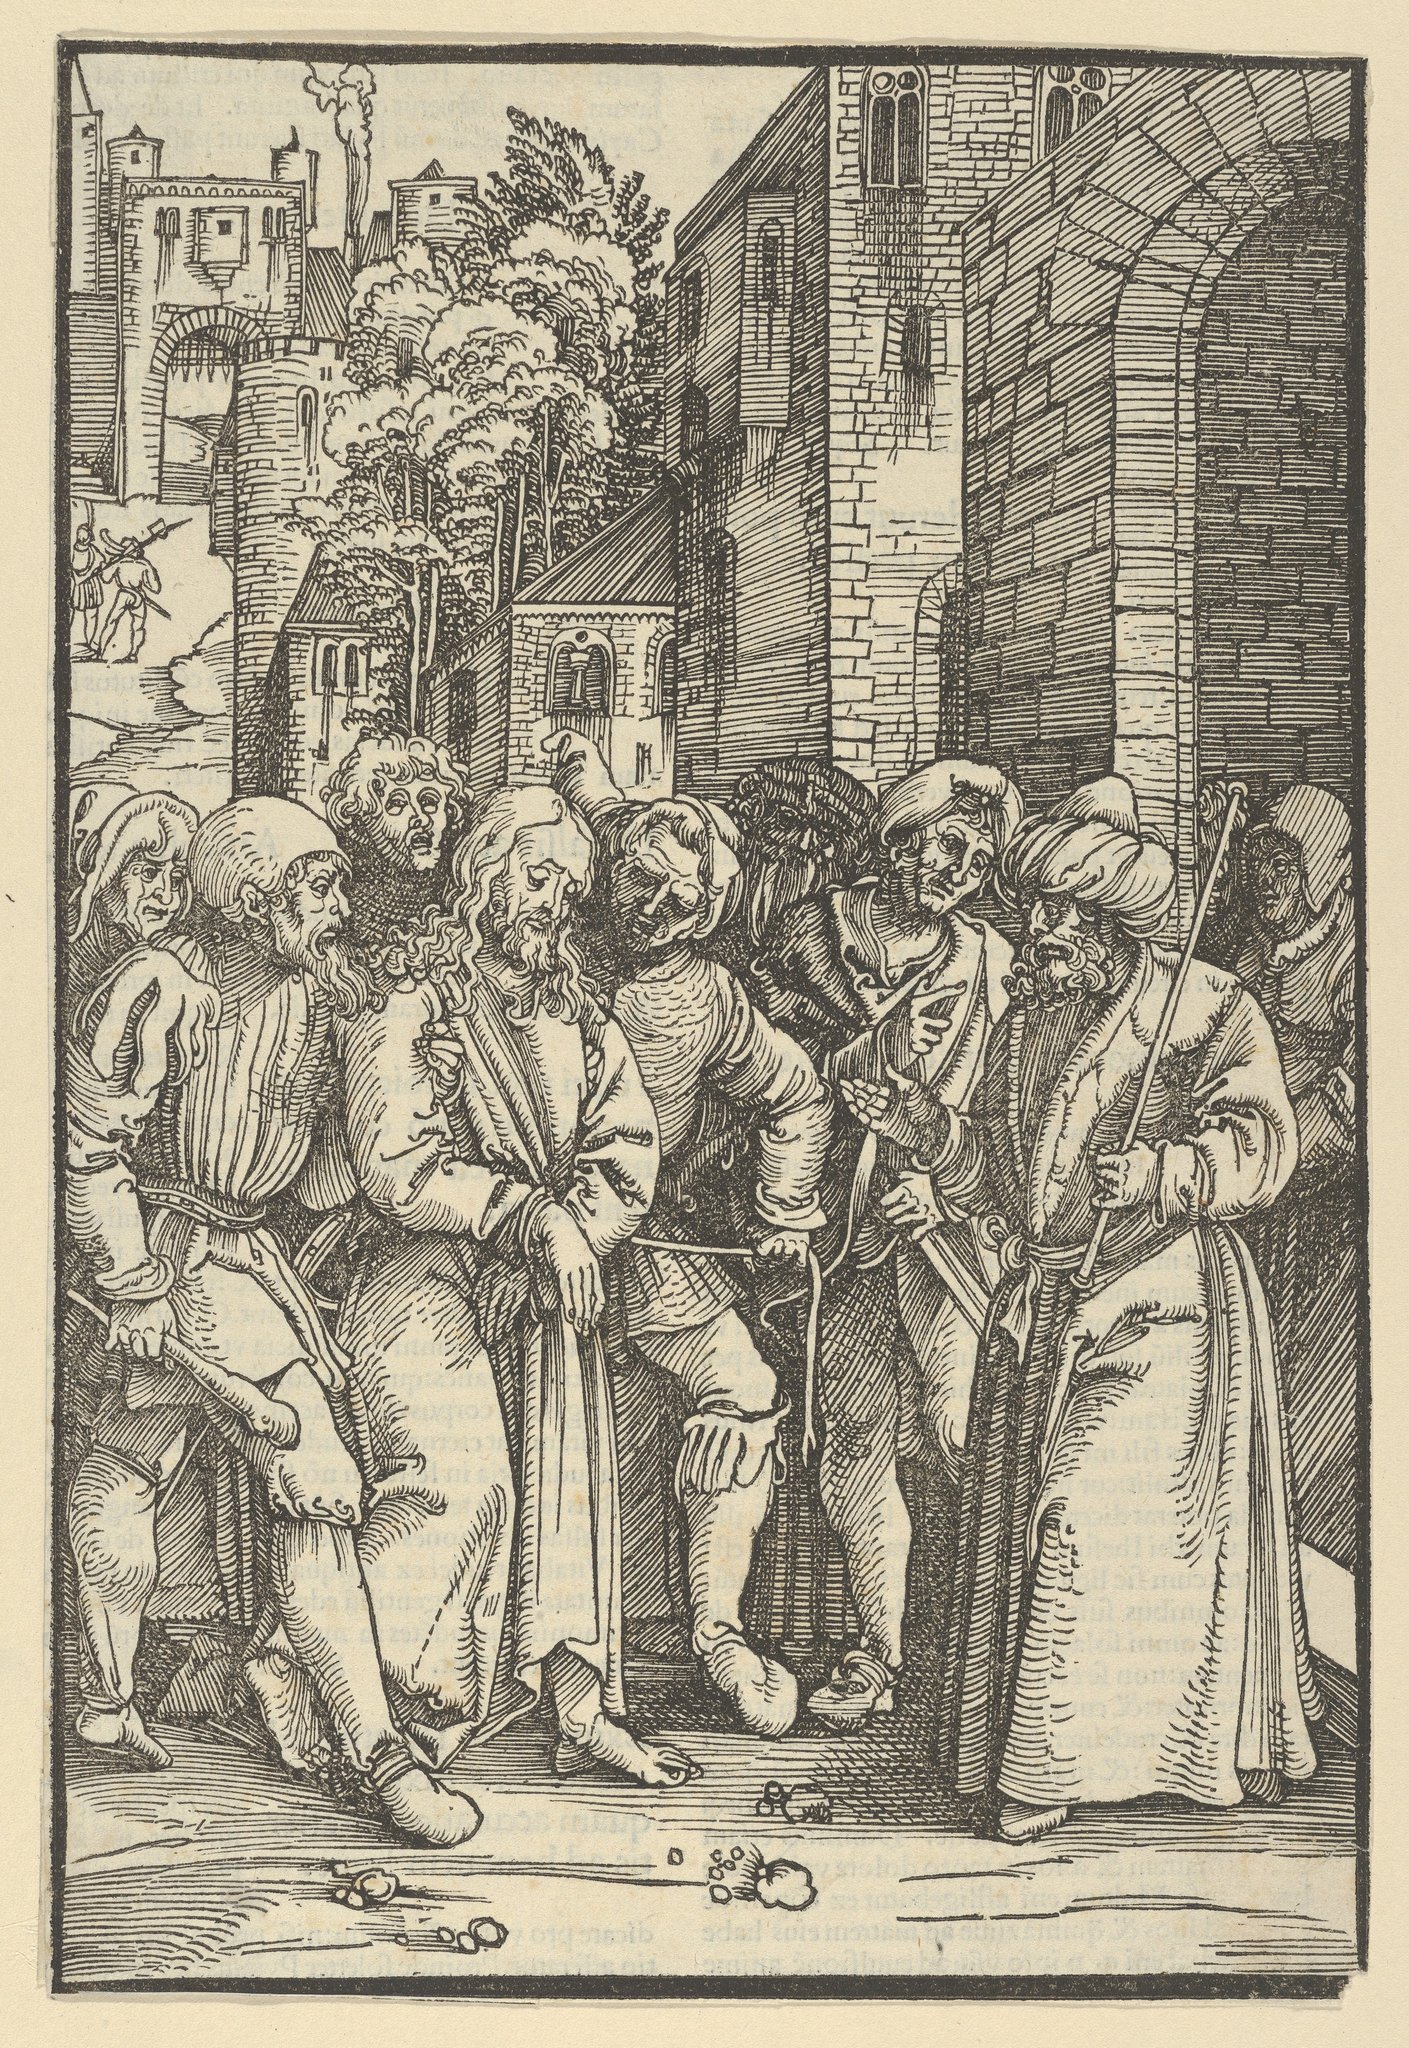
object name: print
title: Christ before Pilate in front of his Palace, from Speculum passionis domini nostri Ihesu Christi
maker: hans schäufelein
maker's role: artist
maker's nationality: german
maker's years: 1480-1540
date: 1507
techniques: woodcut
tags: palaces,men,christ